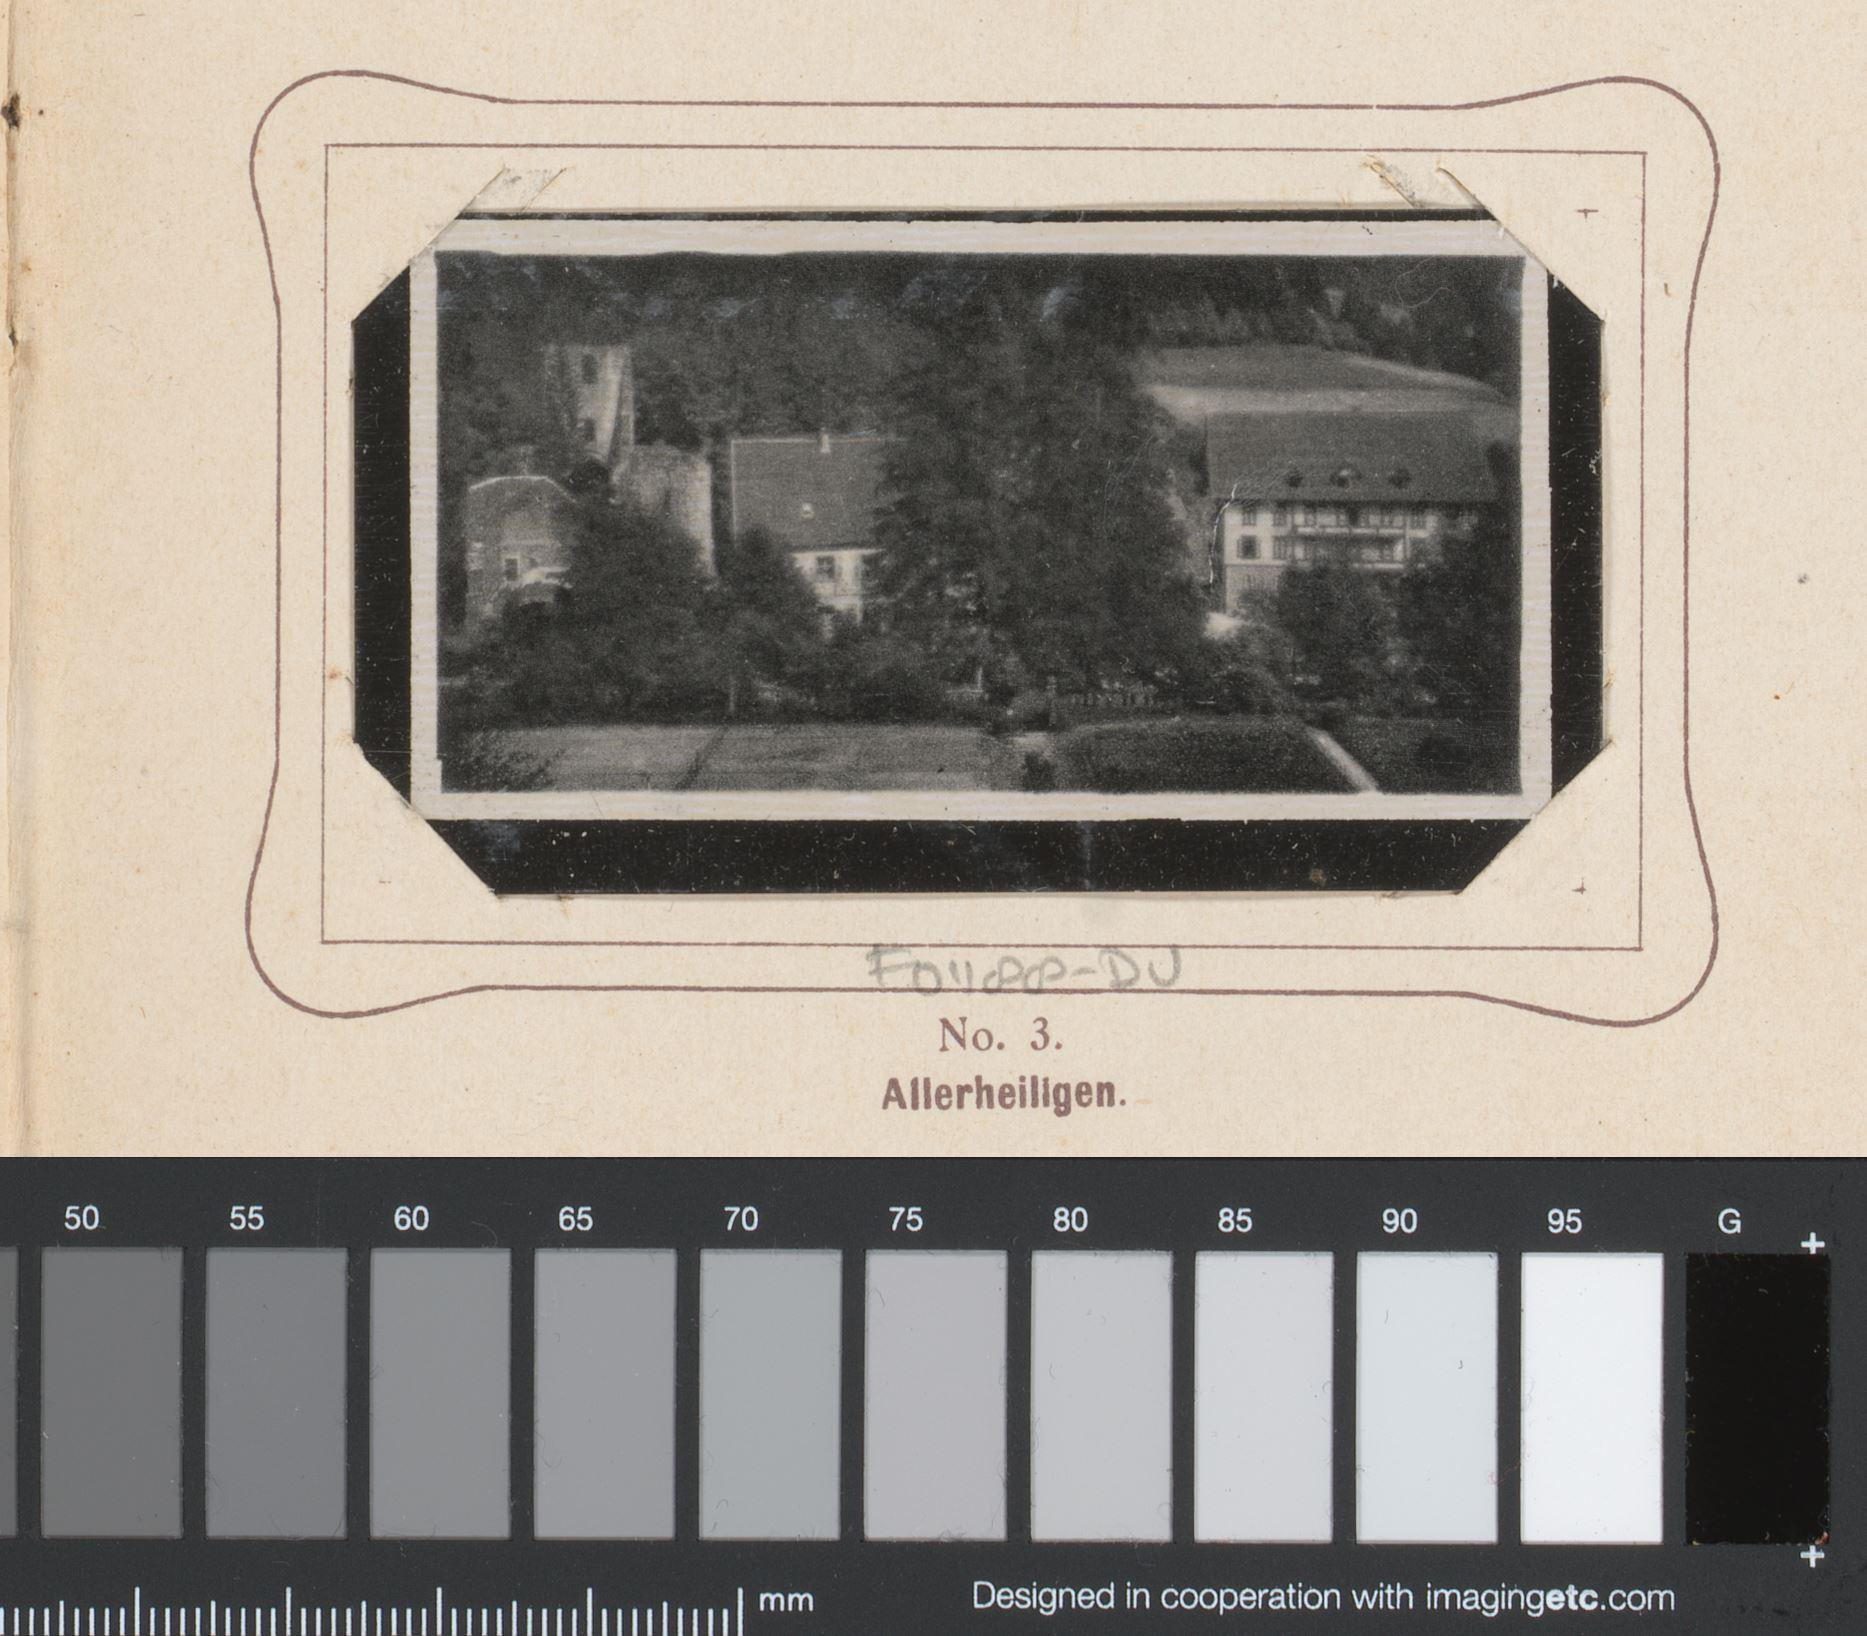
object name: album leaf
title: Gezicht op Allerheiligen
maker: Anonymous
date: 1906-1907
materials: paper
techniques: photograph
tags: city-view in general; 'veduta'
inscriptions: inscription: ‘No. 3./ Allerheiligen.’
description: Deze prent maakt deel uit van een album.